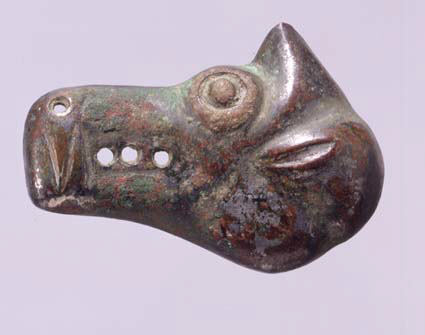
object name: strap crossing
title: Strap-Crossing in the Shape of Camel's Head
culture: northwest chinese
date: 400-201 BCE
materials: bronze